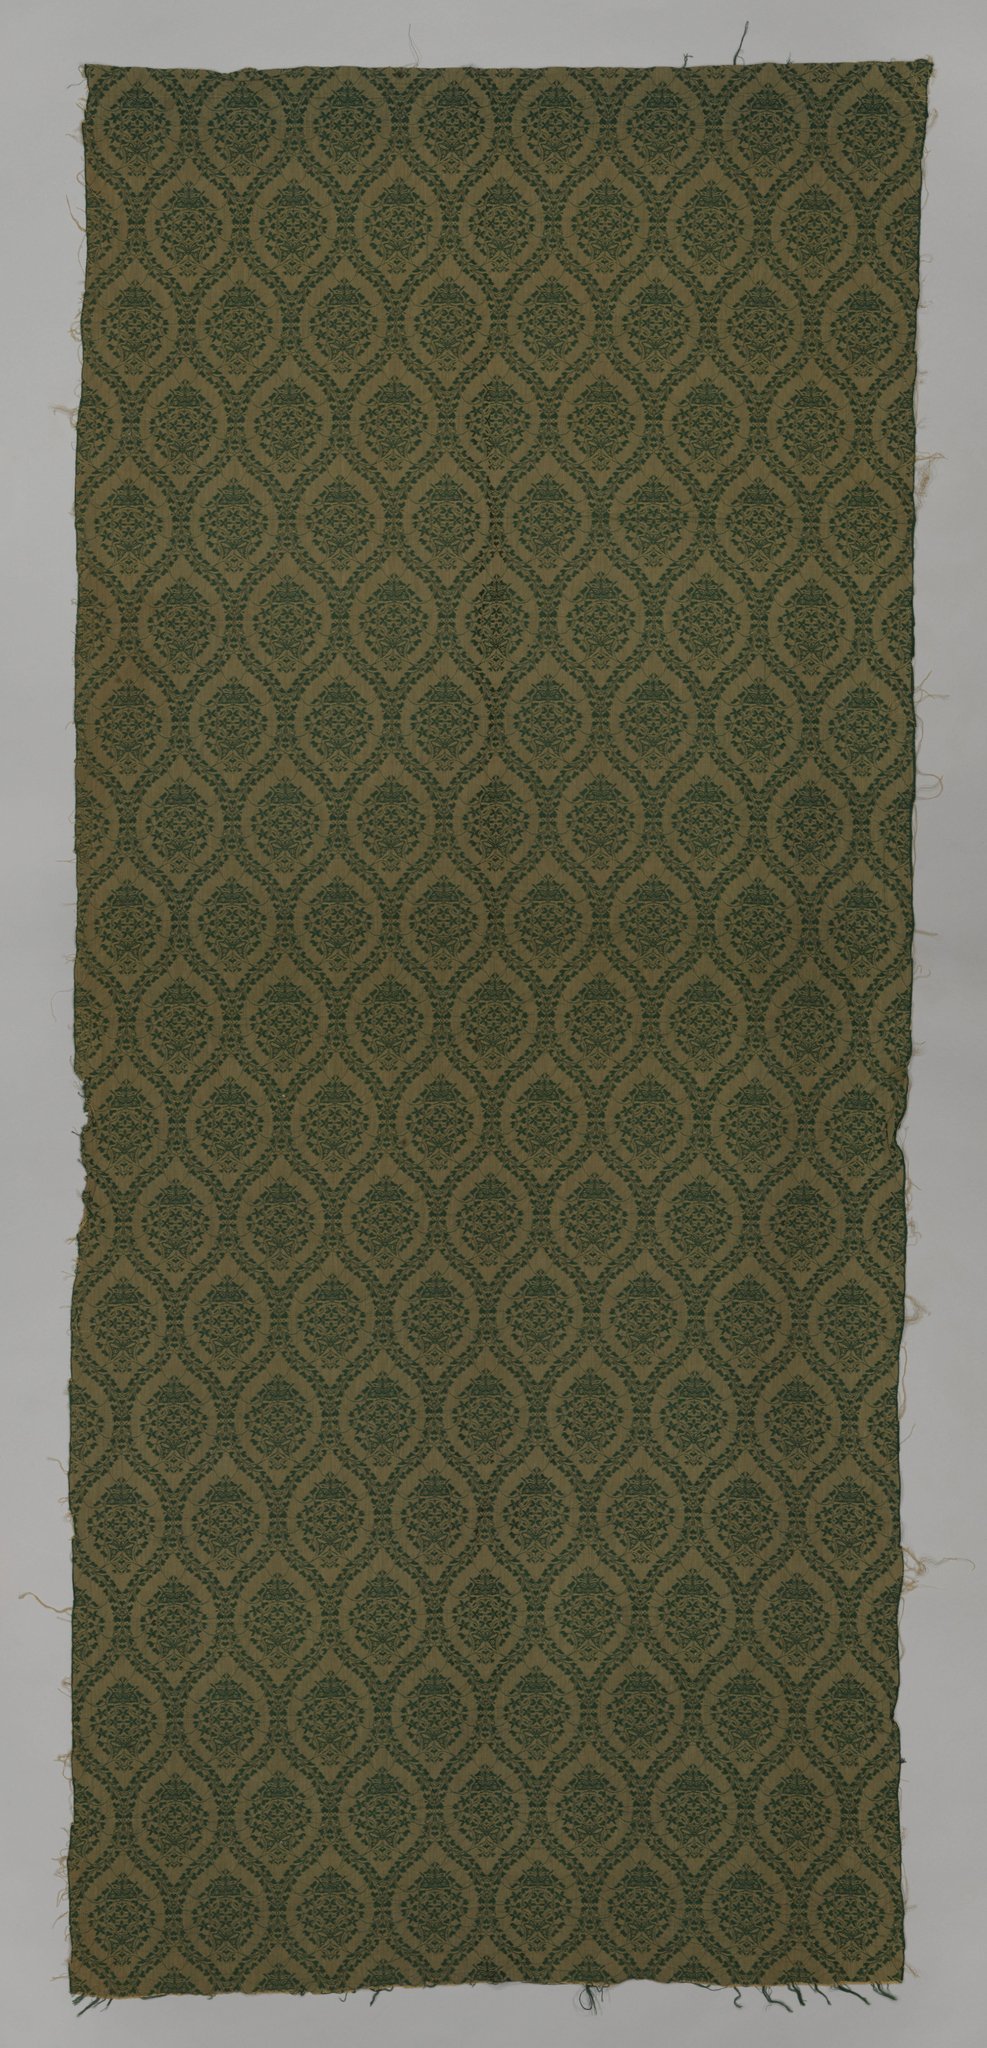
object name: upholstery fabric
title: Bespanningsstof, jacquardweefsel met patroon van spitsovale velden met bladranken, donkergroene inslag op zachtgele ketting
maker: theo nieuwenhuis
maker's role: designer, draughtsman, print maker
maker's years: 1866-1951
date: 1920-1930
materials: wool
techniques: jacquard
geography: helmond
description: Bespanningsstof, jacquardweefsel met patroon van spitsovale velden met bladranken, donkergroene inslag op zachtgele ketting.